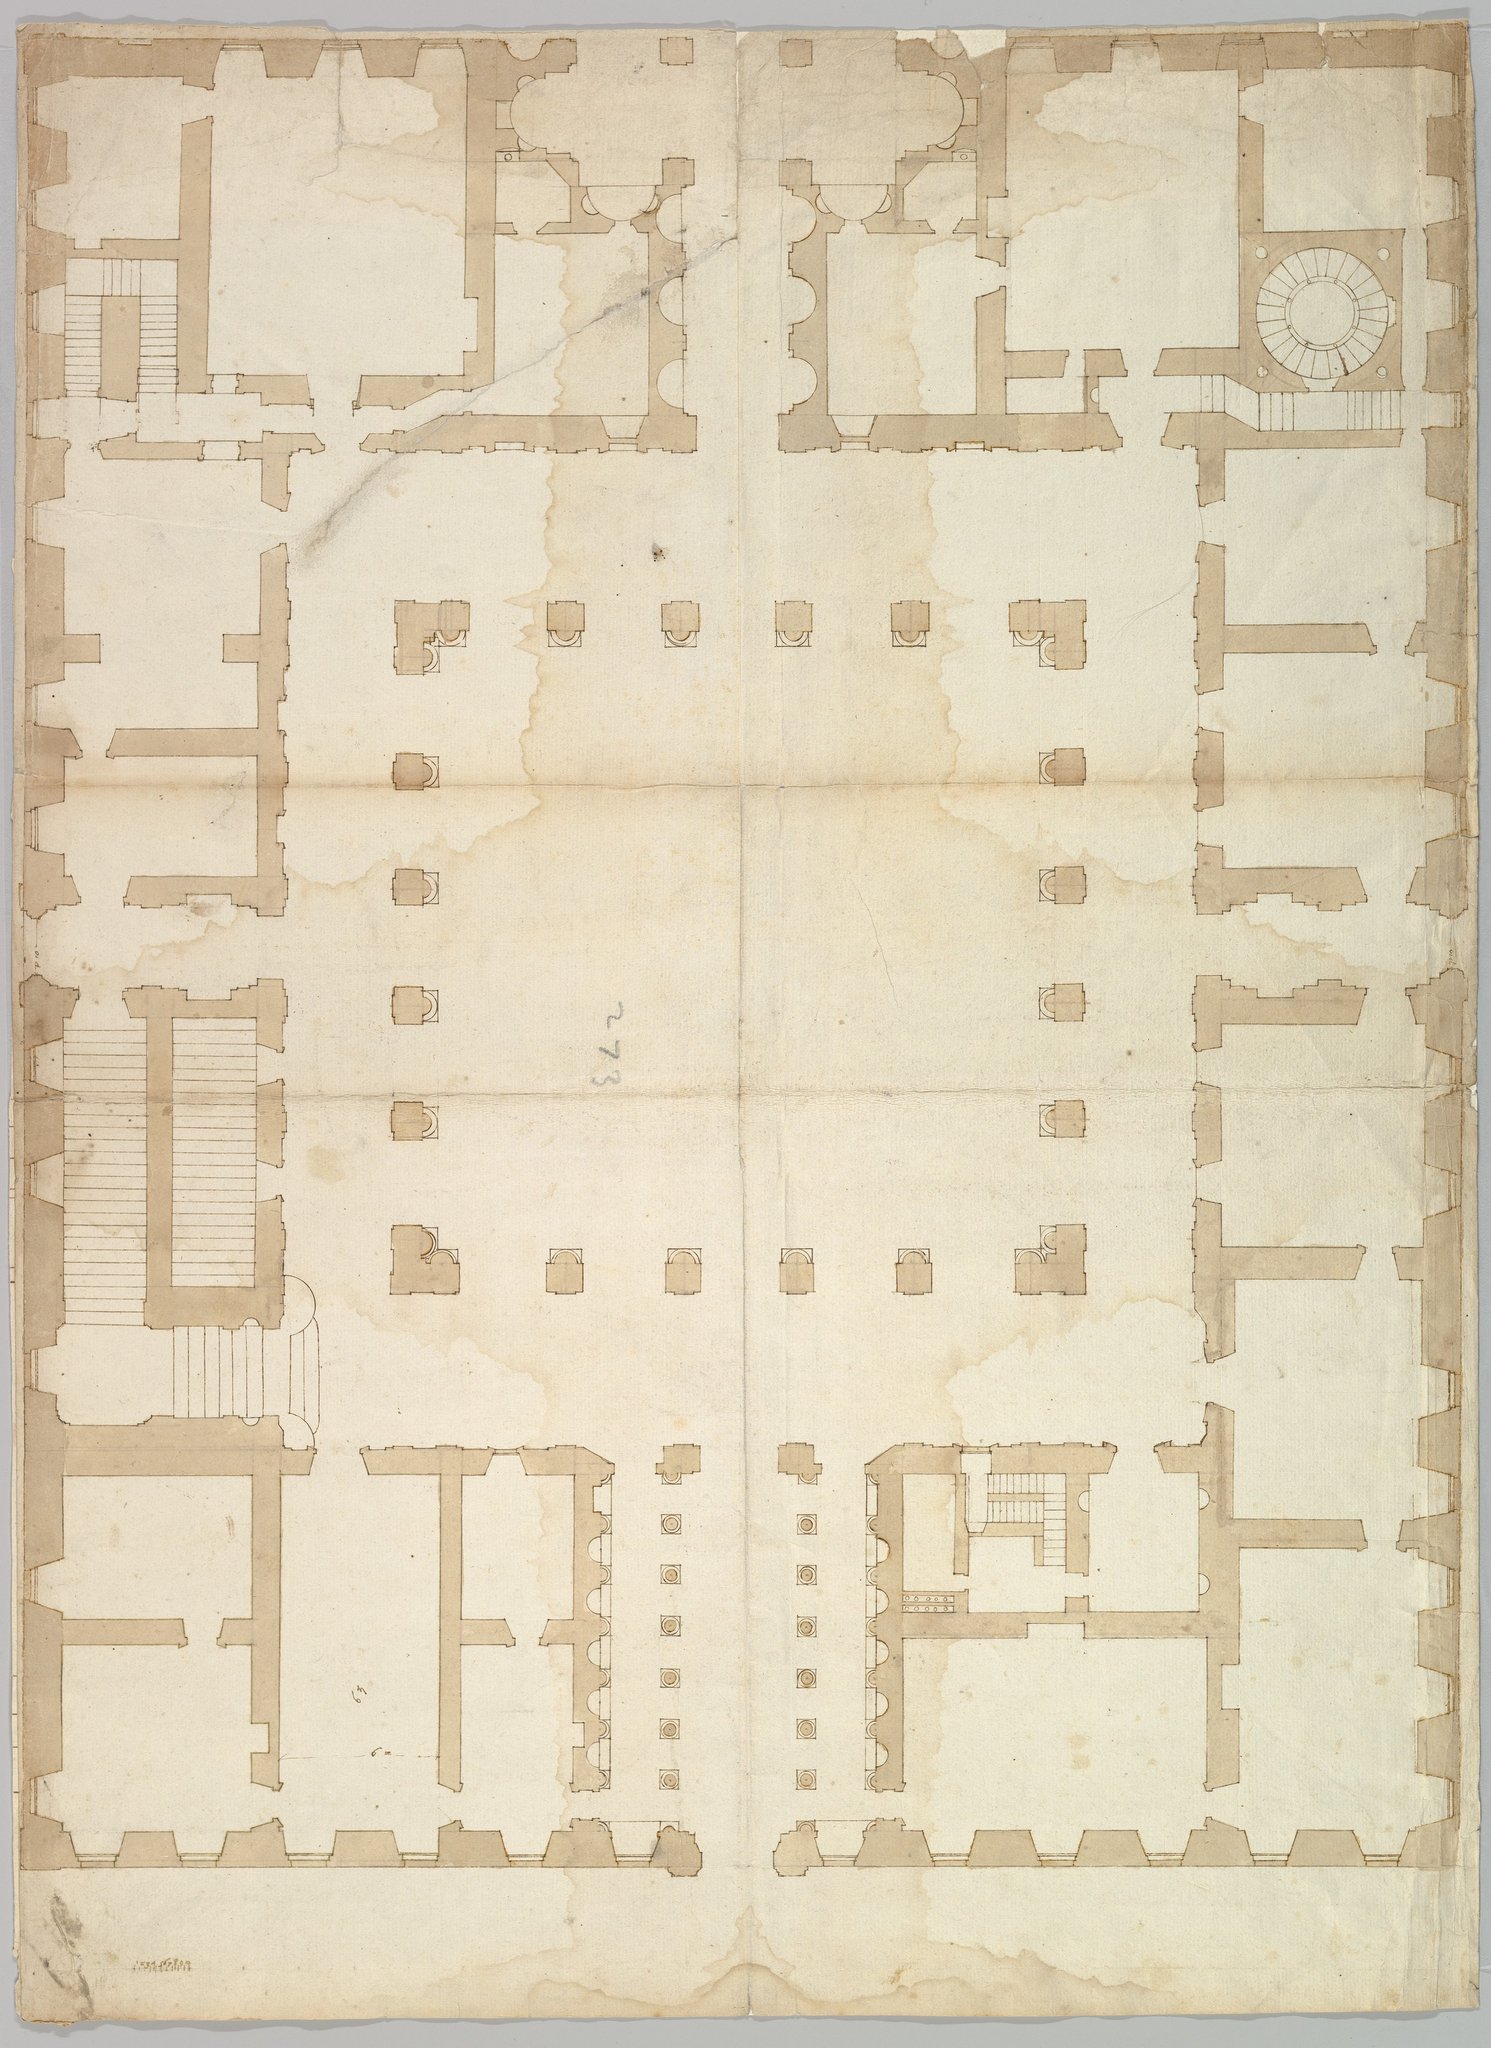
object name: drawing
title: Palazzo Farnese, plan, ground floor (recto) blank (verso)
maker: anonymous, french, 16th century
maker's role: draftsman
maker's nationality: french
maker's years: 1500-1600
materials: chalk, ink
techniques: incising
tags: architecture